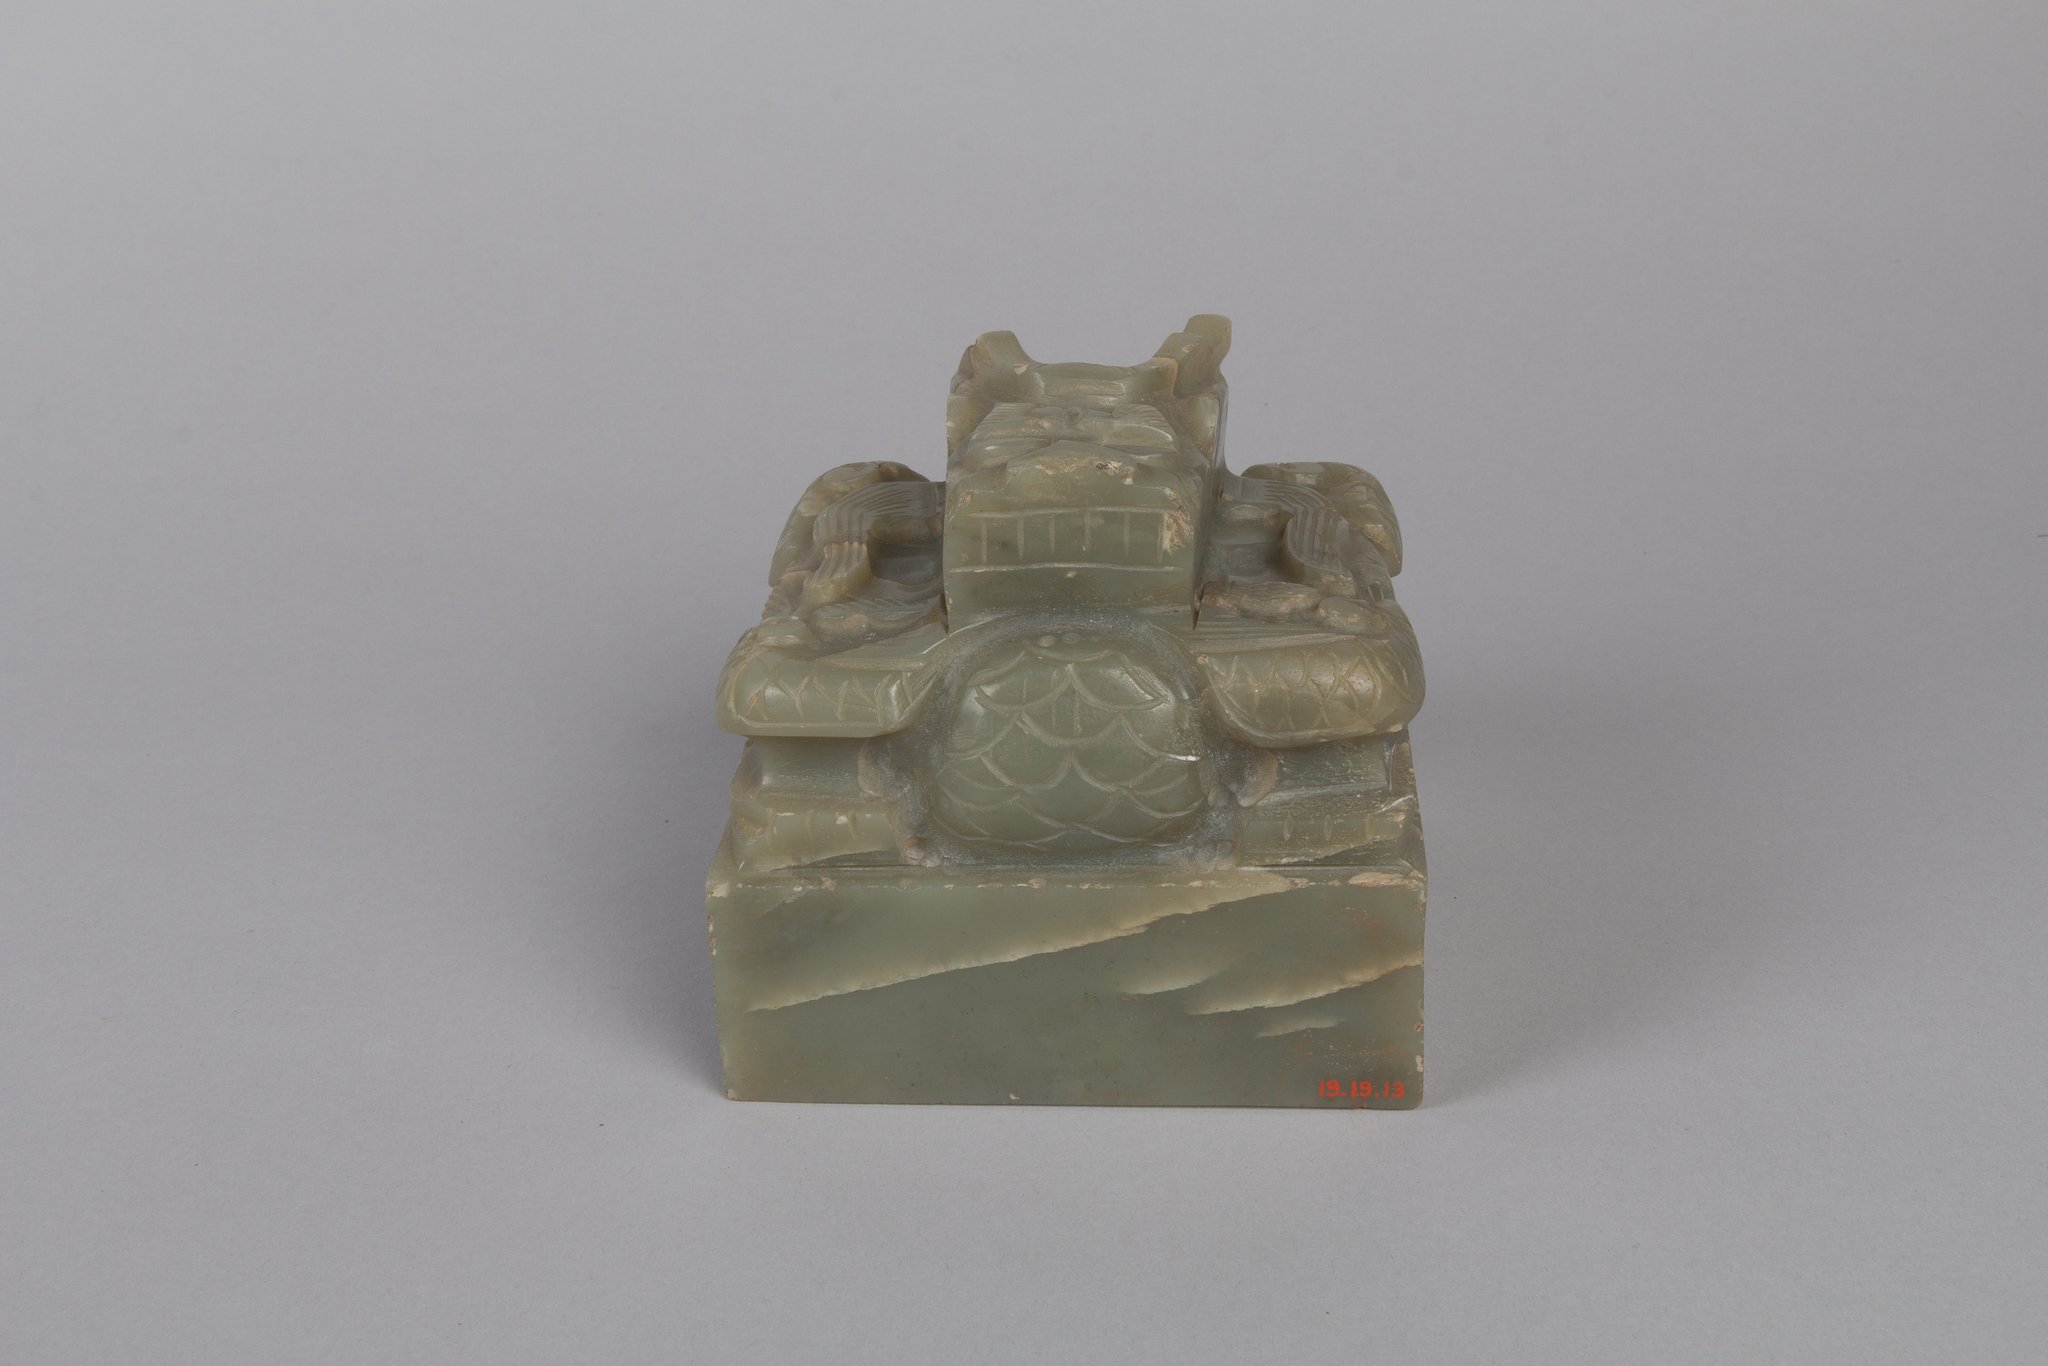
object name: seal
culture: chinese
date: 1901-1933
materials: jade